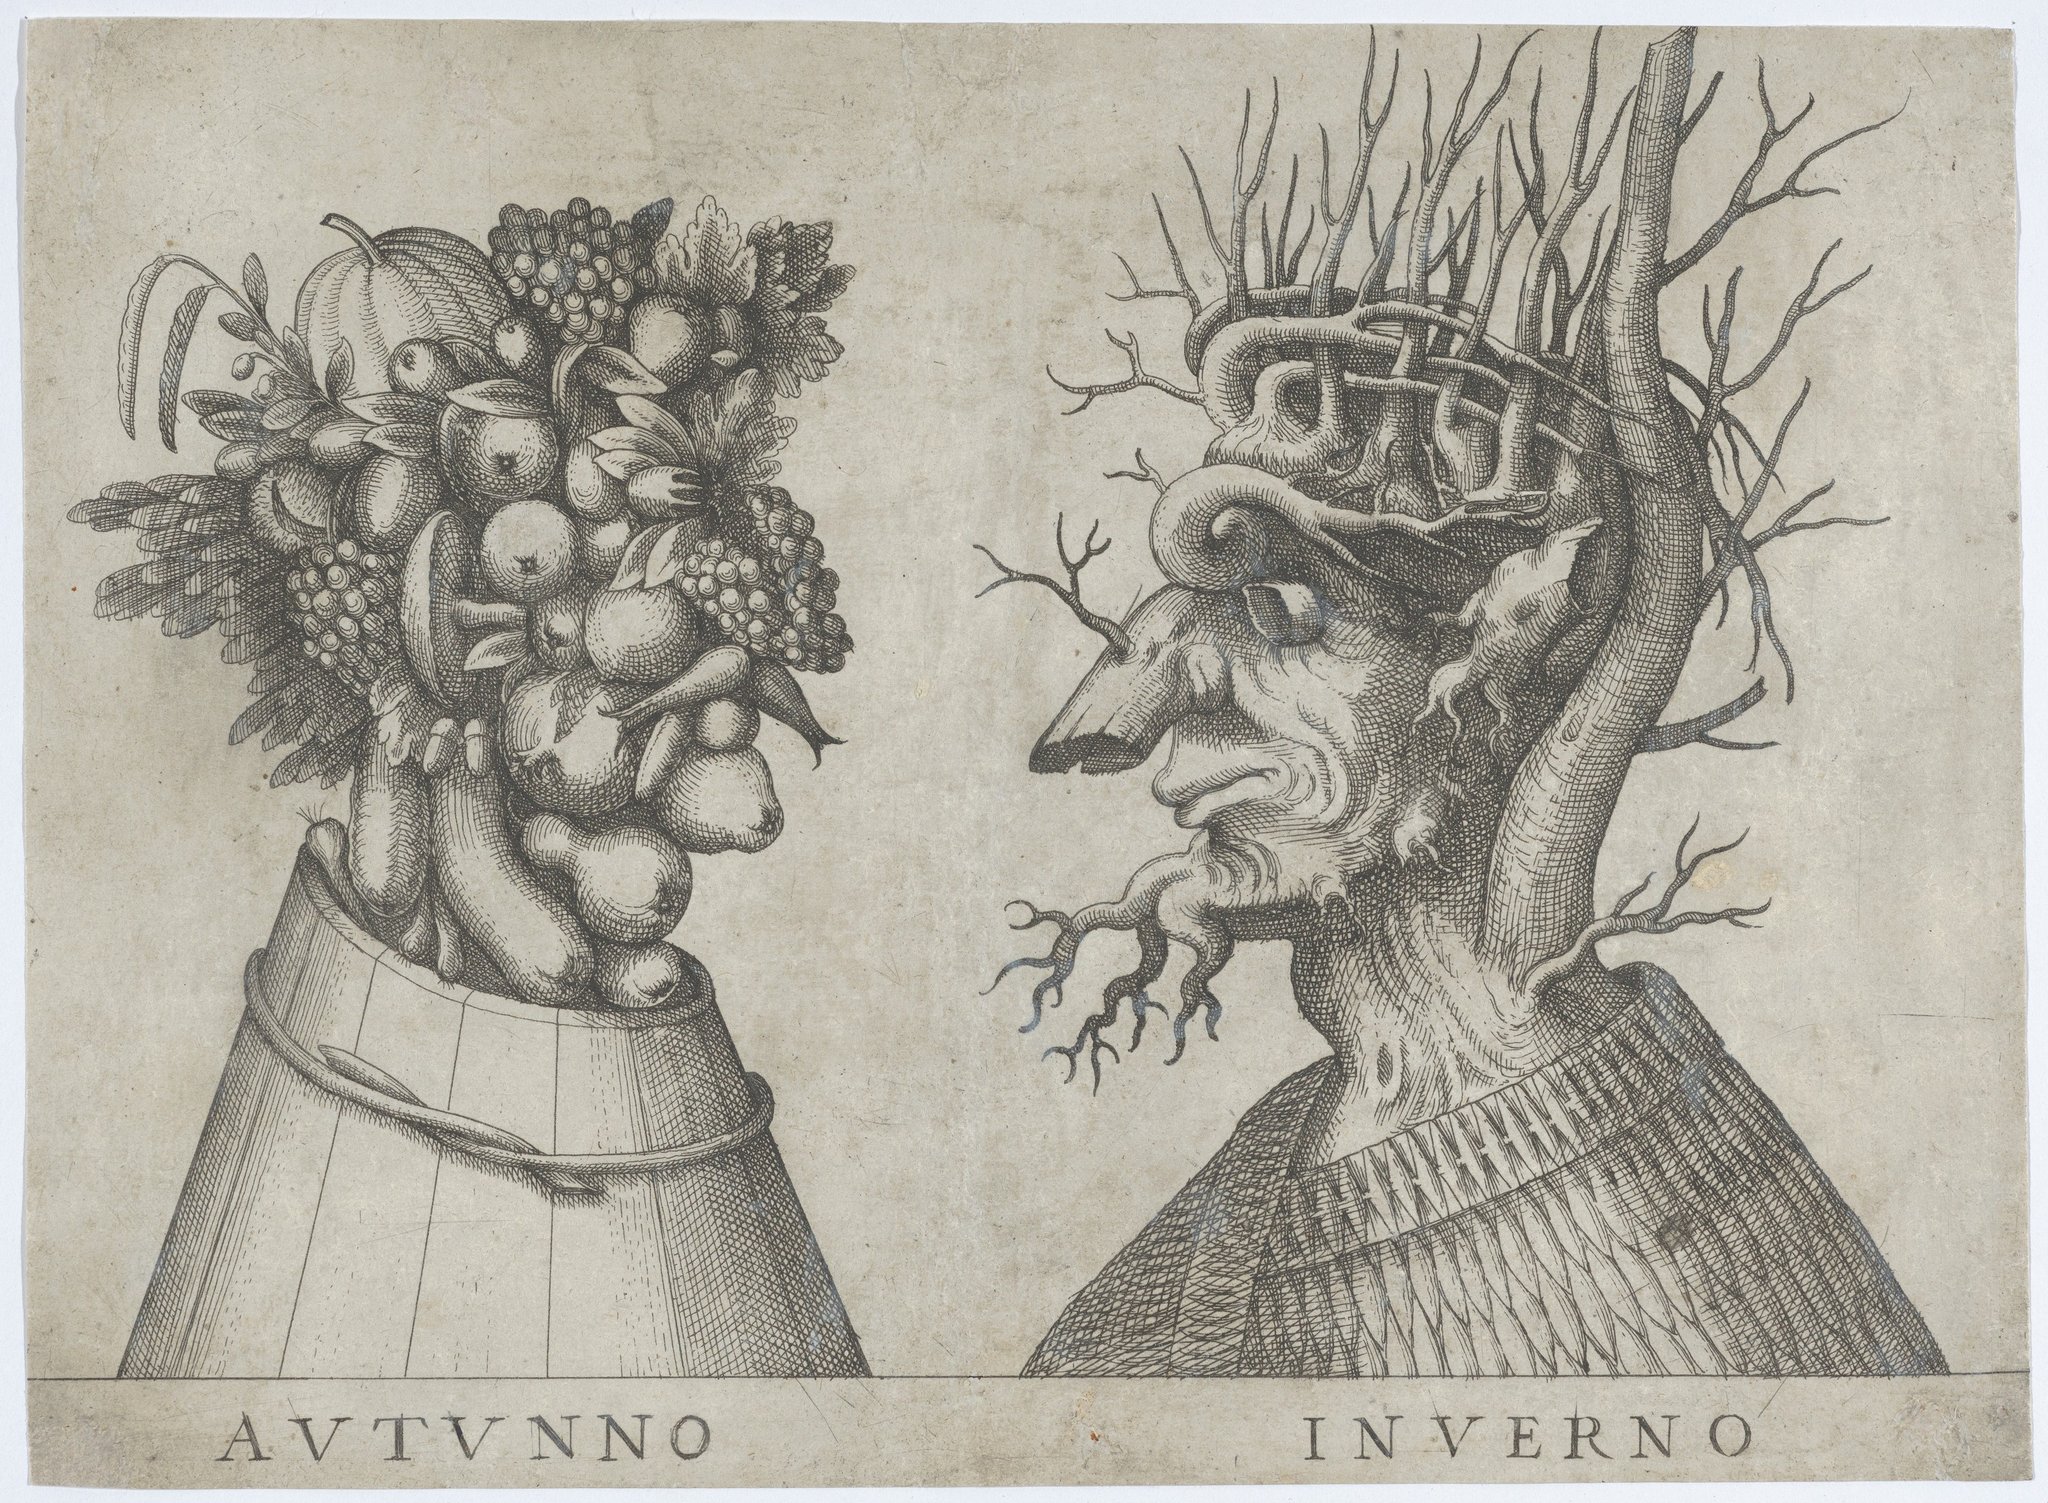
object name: print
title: Autumn and Winter: two heads made from flora typical of those seasons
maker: anonymous, italian, 16th to early 17th century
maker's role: artist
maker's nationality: italian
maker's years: 1500-1640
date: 1580-1620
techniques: etching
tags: fruit,trees,autumn,winter